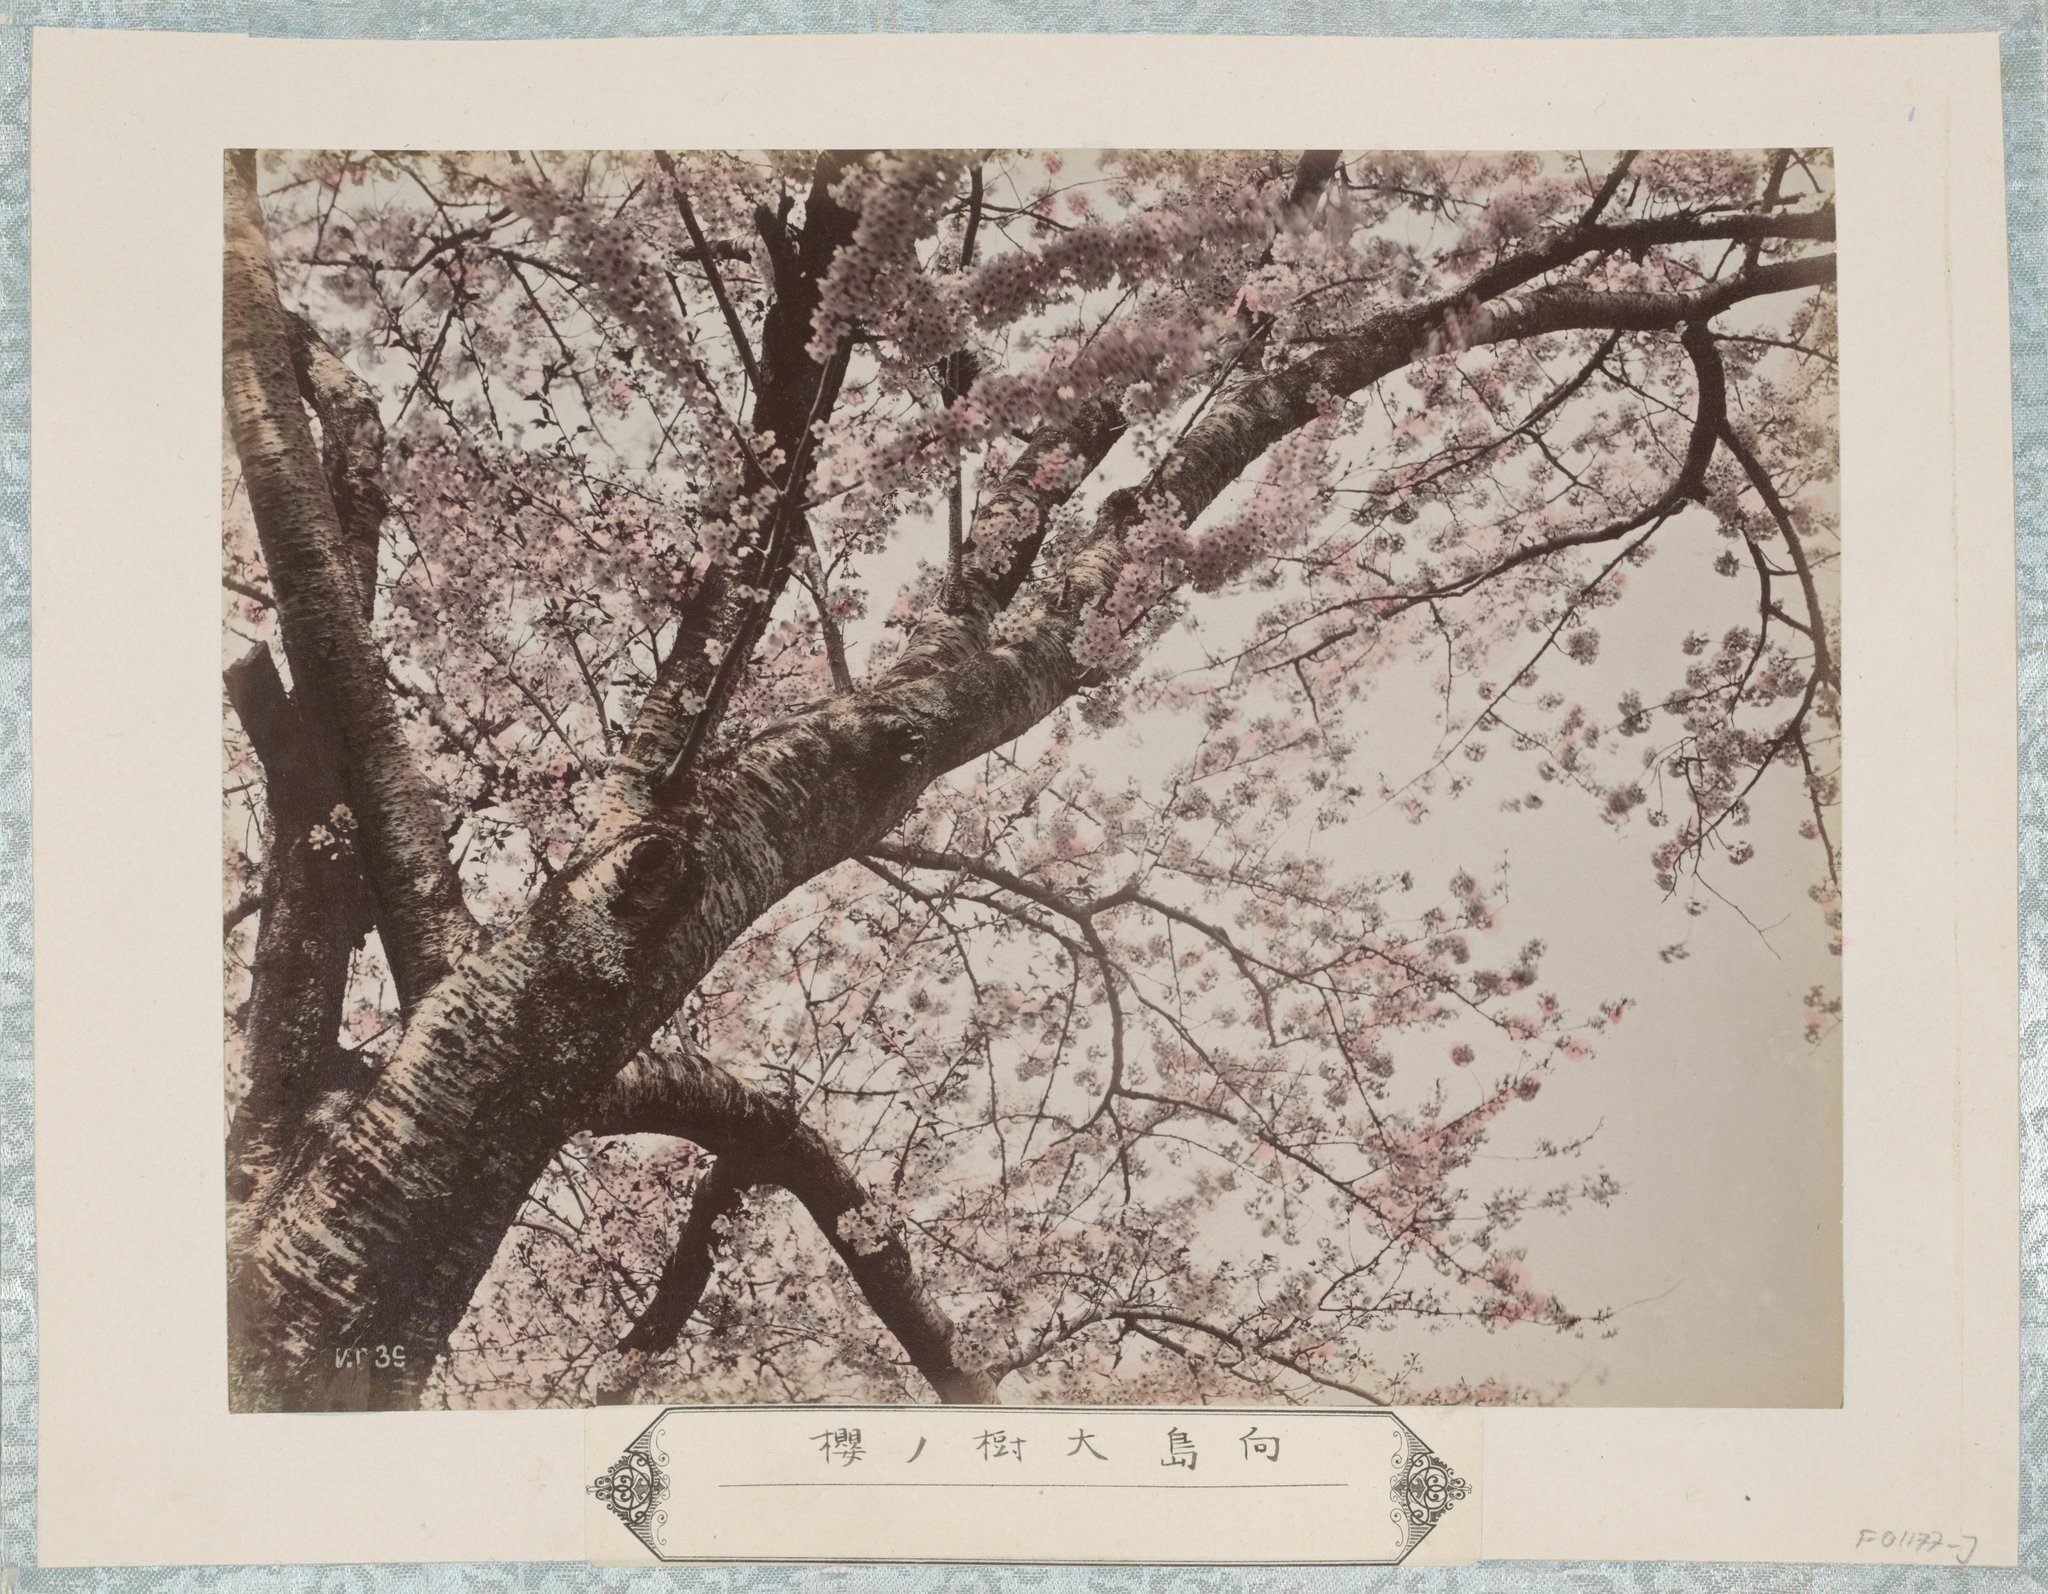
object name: photograph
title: Grote kersenbloesemboom van Mukaijima in Kyoto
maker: Anonymous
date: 1870-1900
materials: cardboard, paper, photographic support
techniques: albumen print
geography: kyoto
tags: trees: cherry-tree (flowers, blossom, blossoming), trees (+ stem, trunk), travelling; tourism, japan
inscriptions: negative number: ‘39’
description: Onderdeel van Leporelloalbum met 30 foto's van bezienswaardigheden in Japan.